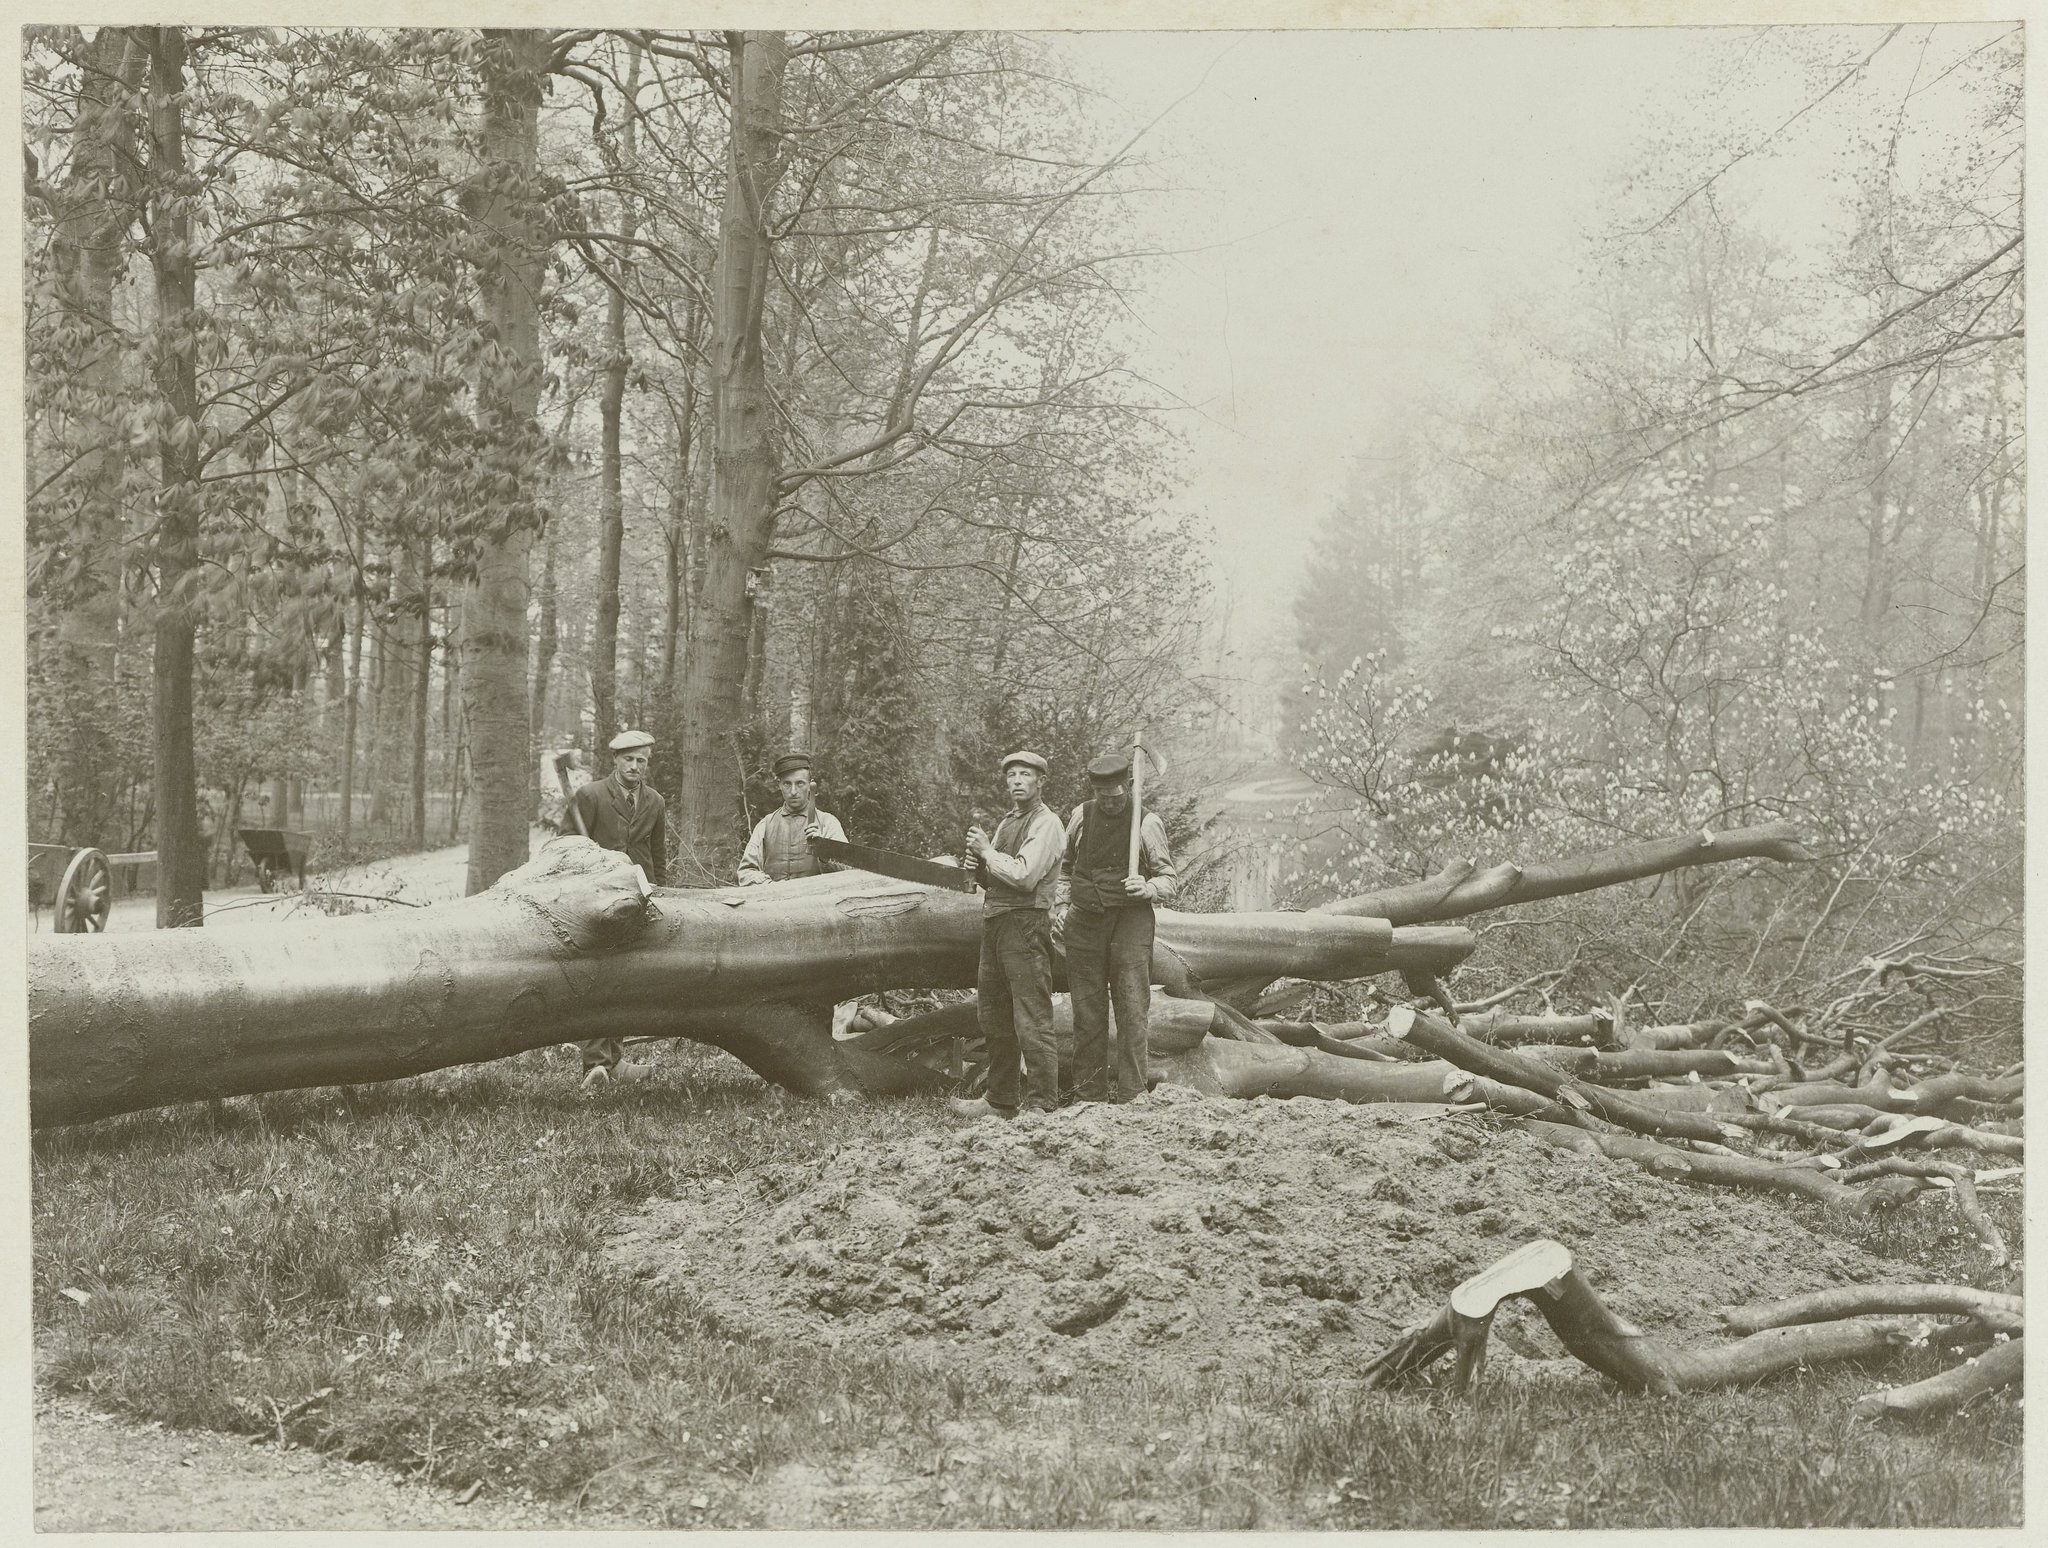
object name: photograph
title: Vier mannen zagen een boom om bij landhuis De Wildbaan, Driebergen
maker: henry pauw van wieldrecht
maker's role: fotograaf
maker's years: 1863-1912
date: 1903-1907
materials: paper, photographic support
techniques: gelatin silver print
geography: netherlands